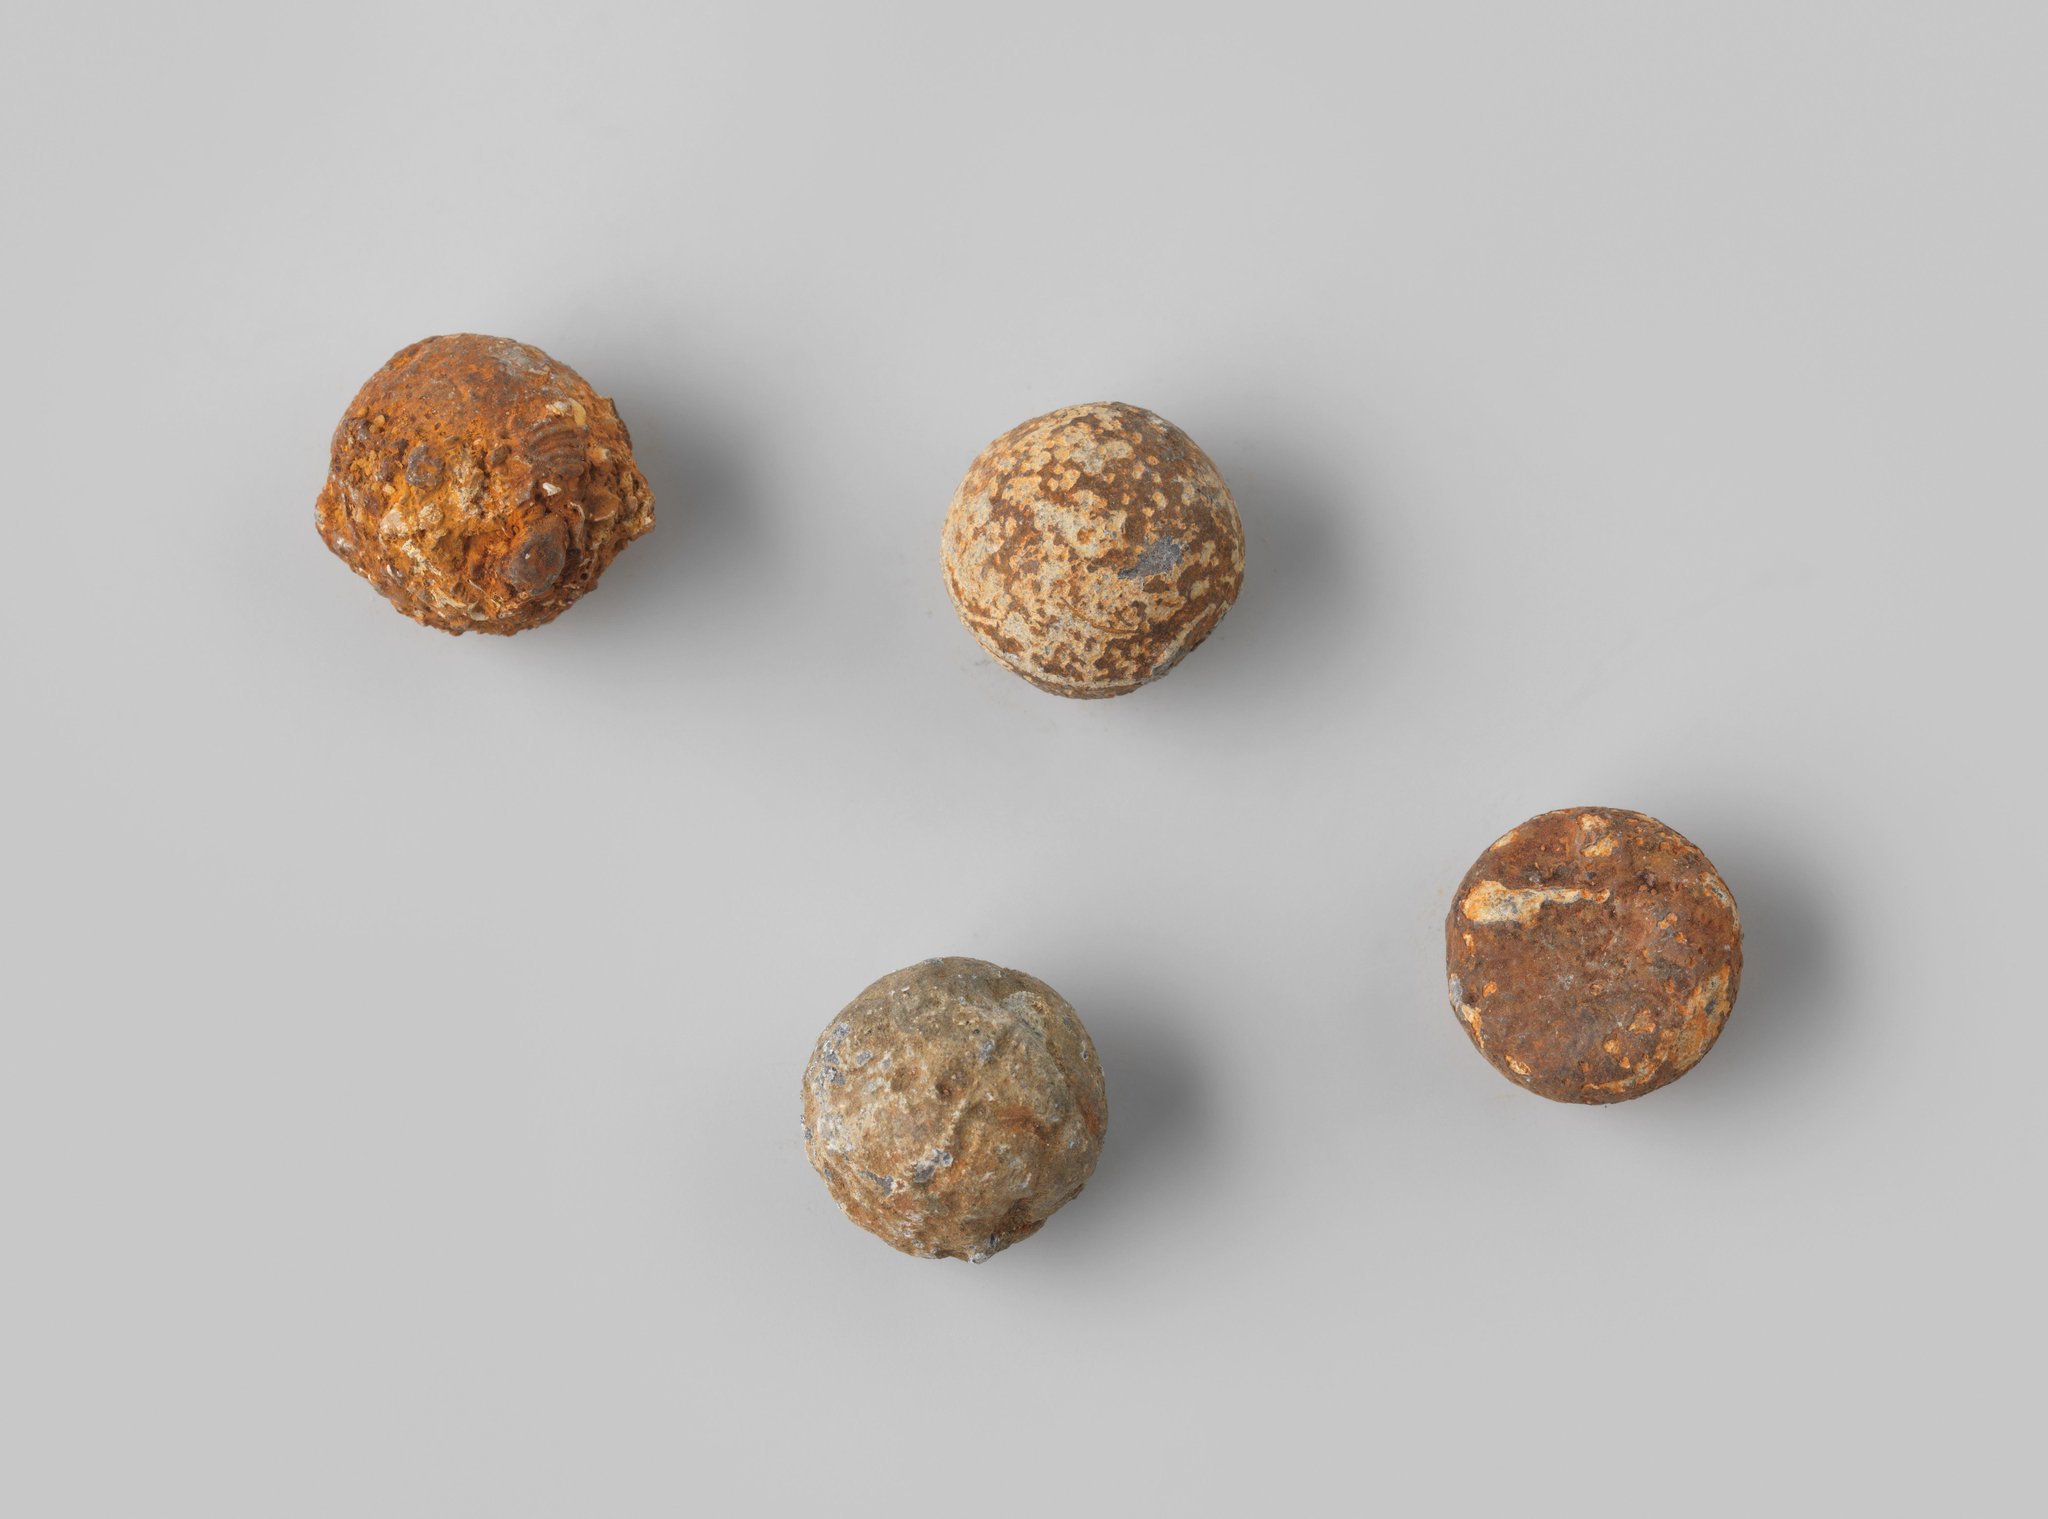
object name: musketkogel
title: Musketkogels uit het wrak van de Oost-Indiëvaarder Hollandia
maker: Anonymous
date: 1700-1743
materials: lead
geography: netherlands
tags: verenigde oostindische compagnie, hollandia (schip), annet